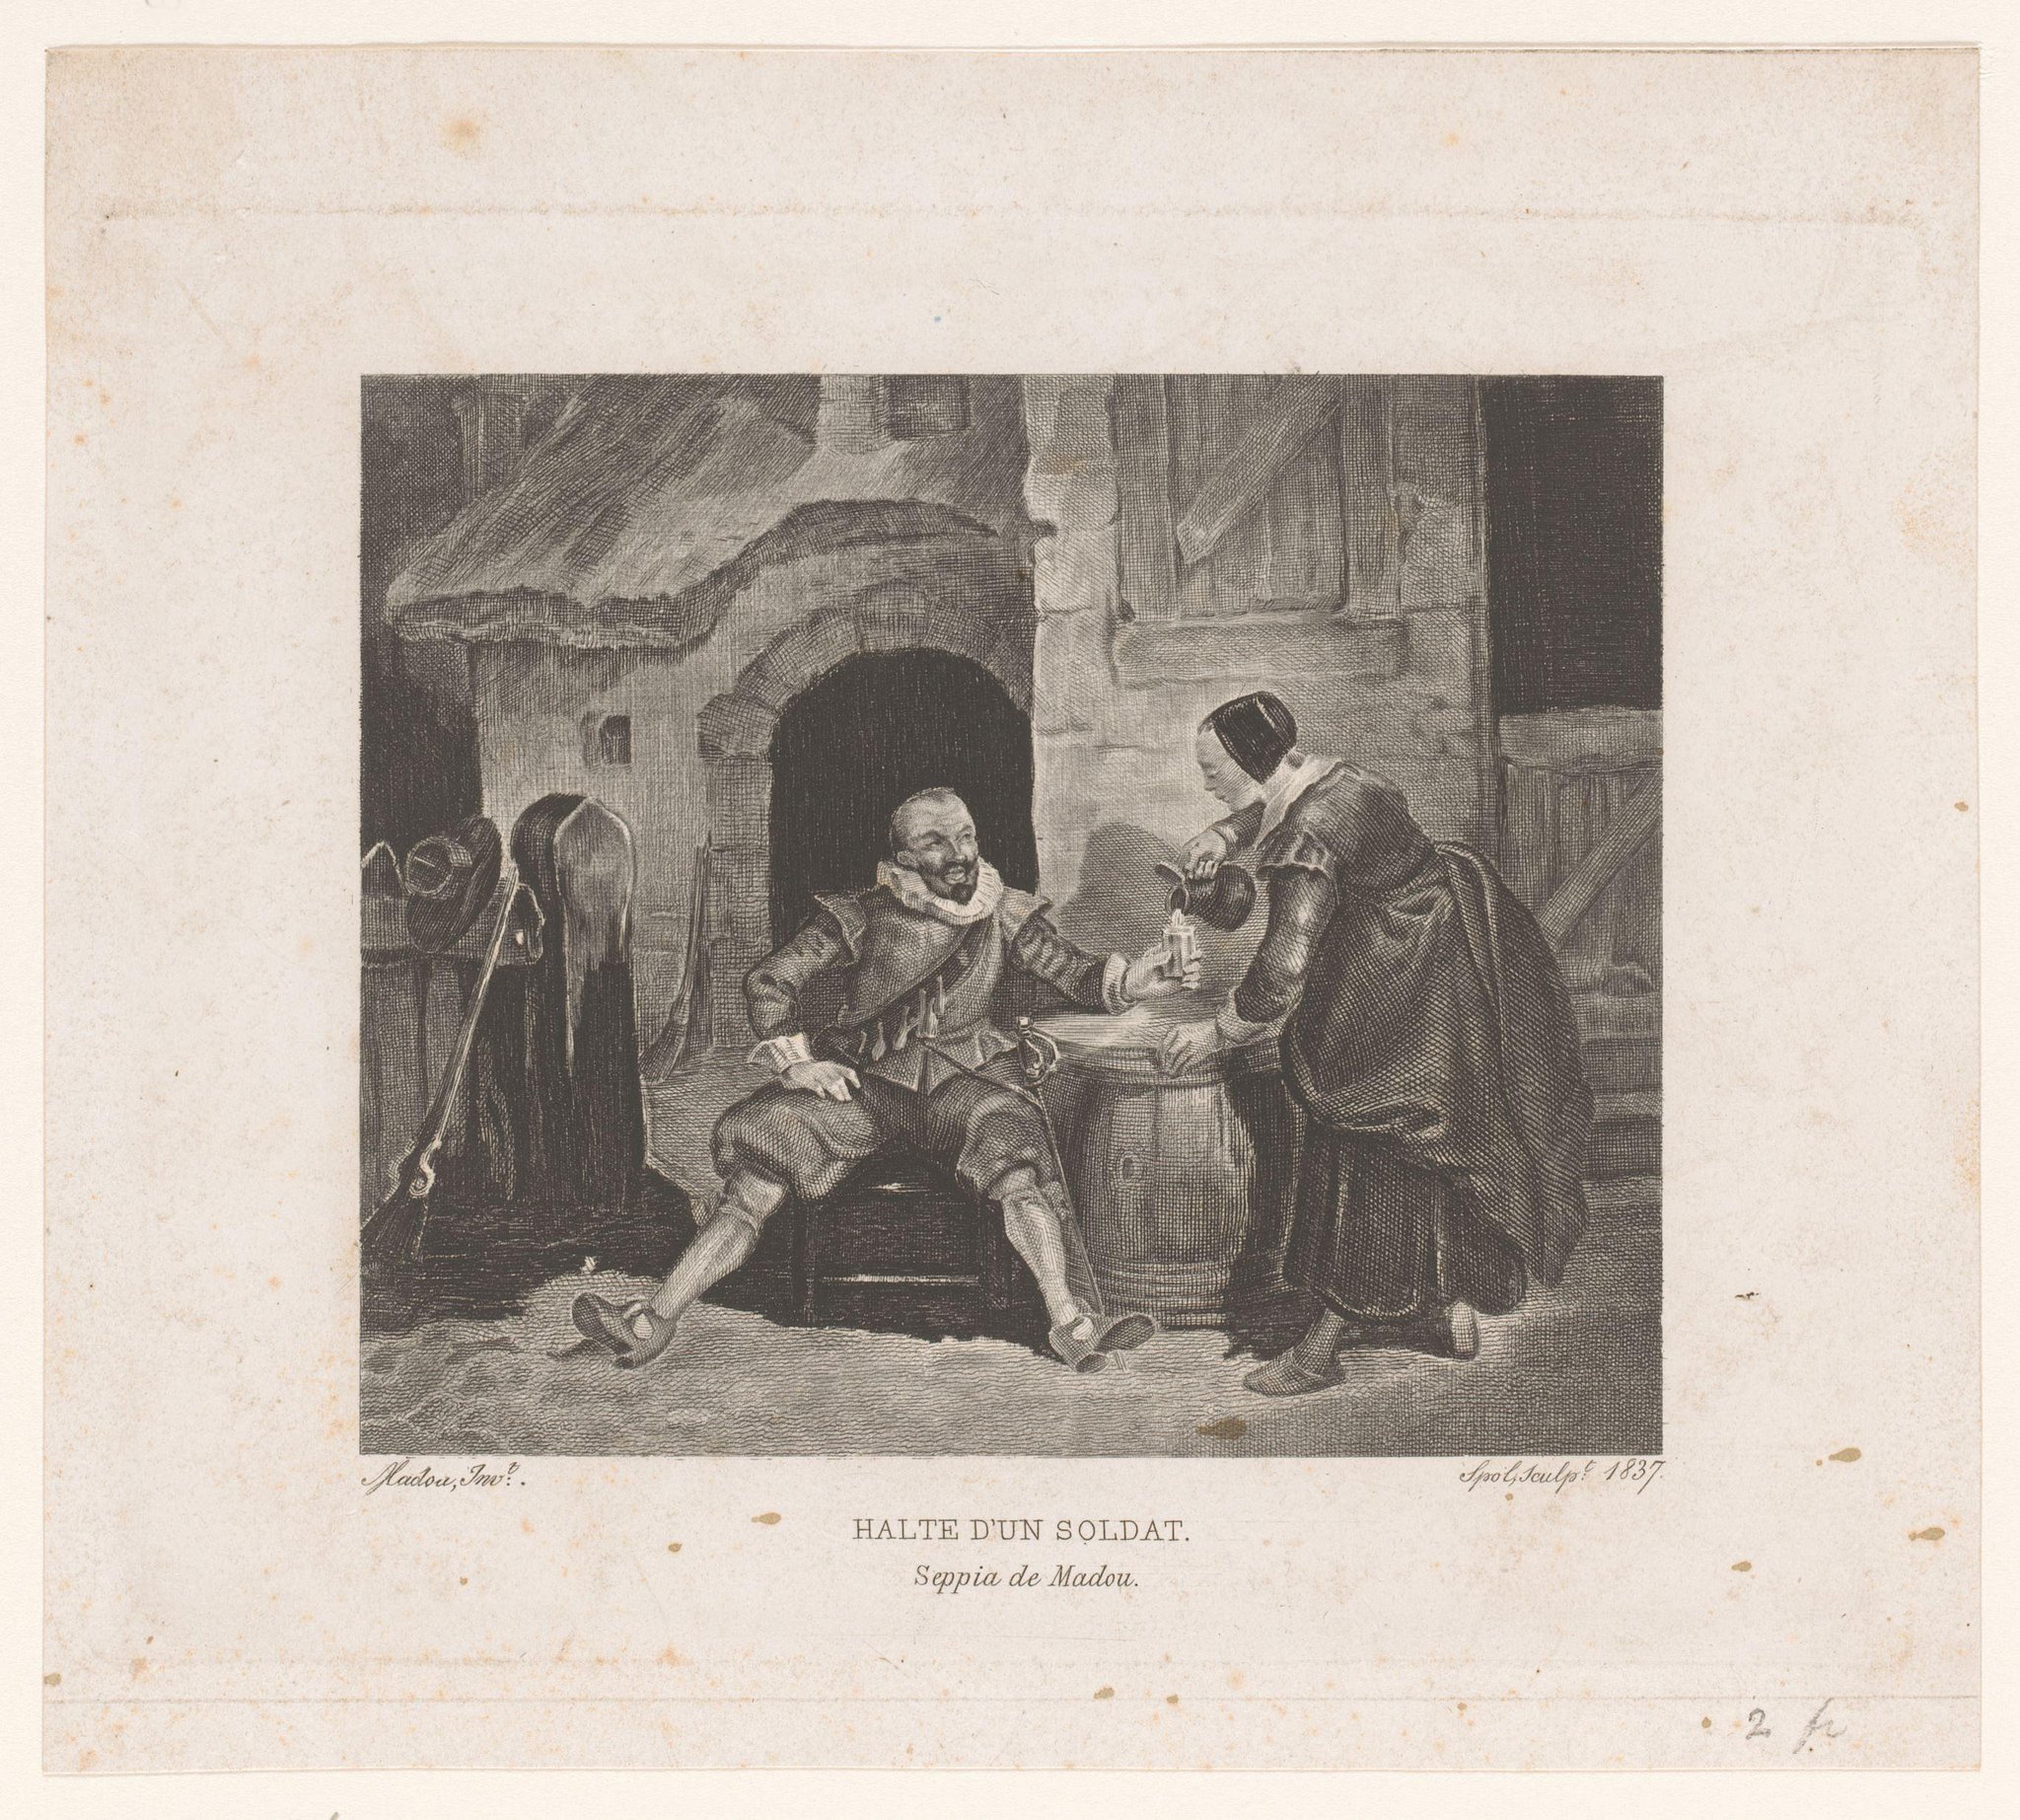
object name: print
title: Halte d'un soldat. Seppia de Madou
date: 1837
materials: paper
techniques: etching, roulette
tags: giving drink, the soldier off duty, hotel, hostelry, inn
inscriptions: collector's mark: Lugt 2228